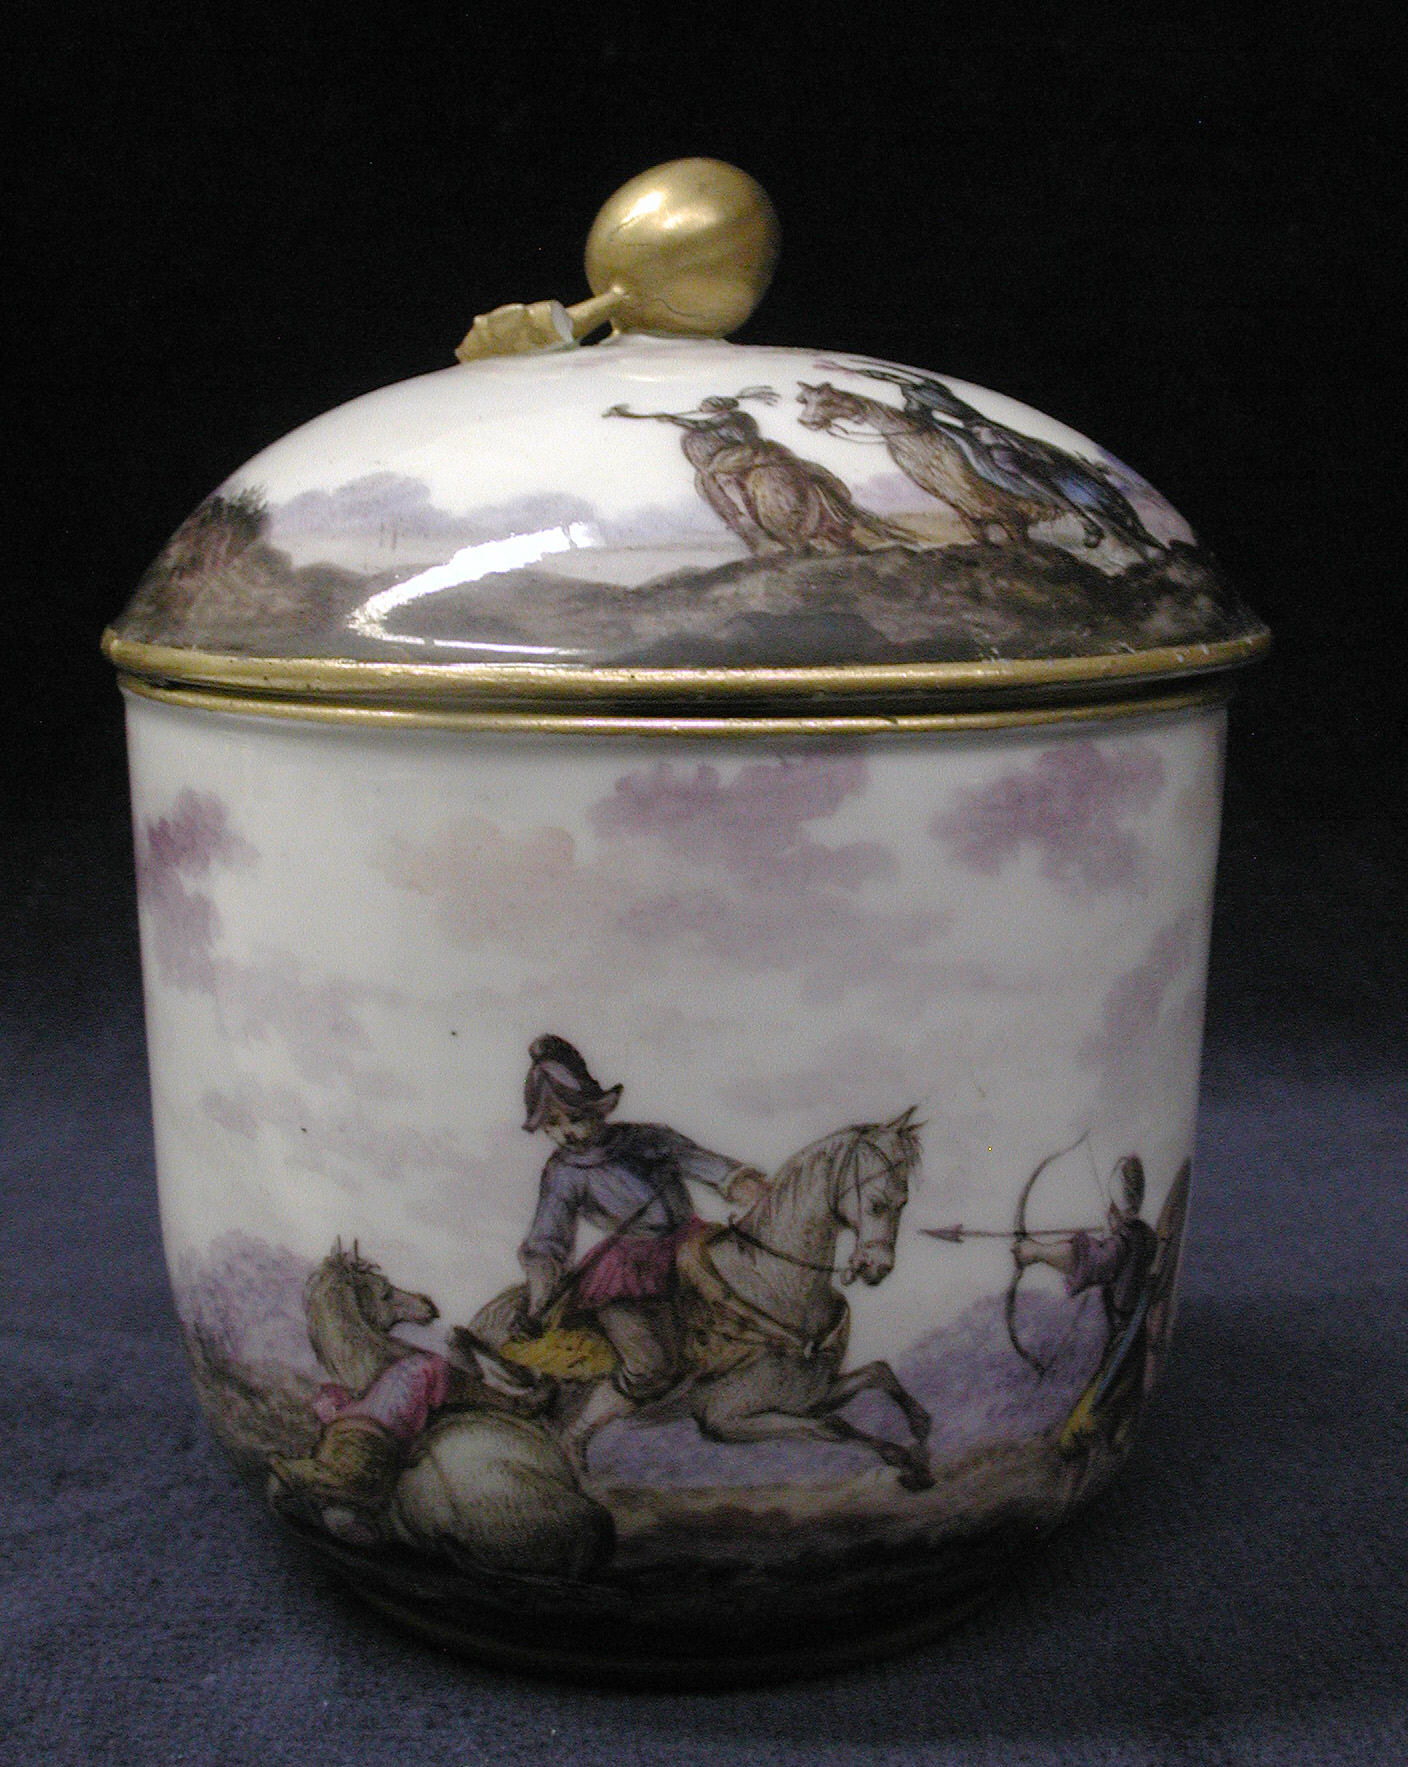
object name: sugar bowl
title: Sugar bowl (part of a service)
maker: capodimonte porcelain manufactory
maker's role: manufactory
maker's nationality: italian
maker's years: 1740-1759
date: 1743-1759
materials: soft paste porcelain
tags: battles,men,horses